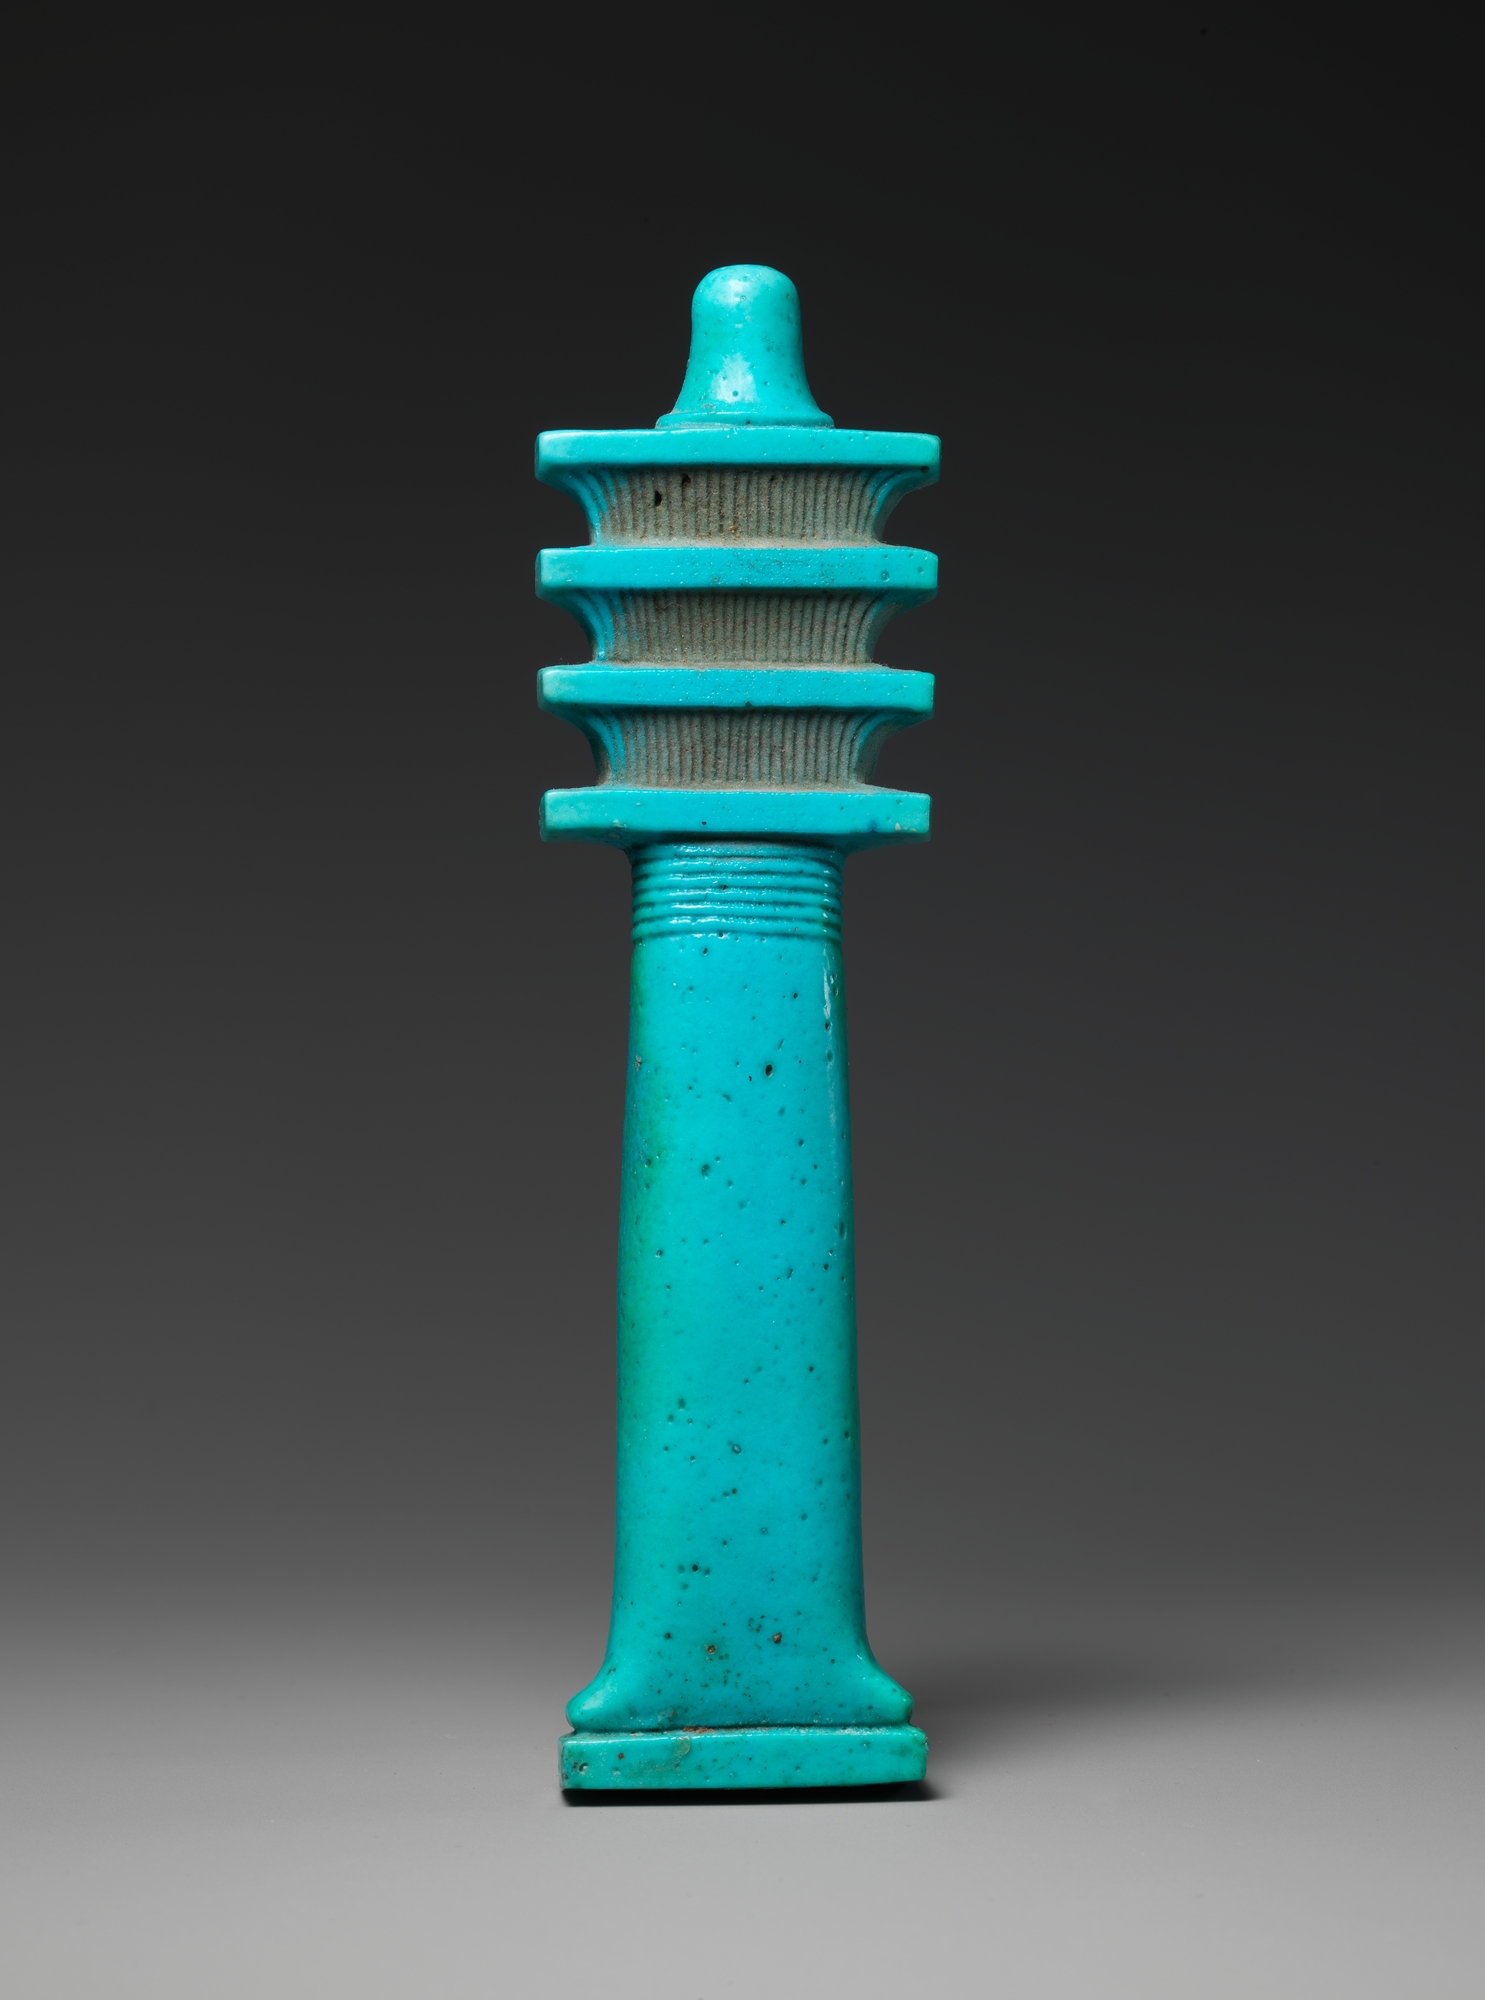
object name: amulet, djed pillar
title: Djed pillar amulet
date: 664-332 BCE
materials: faience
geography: egypt